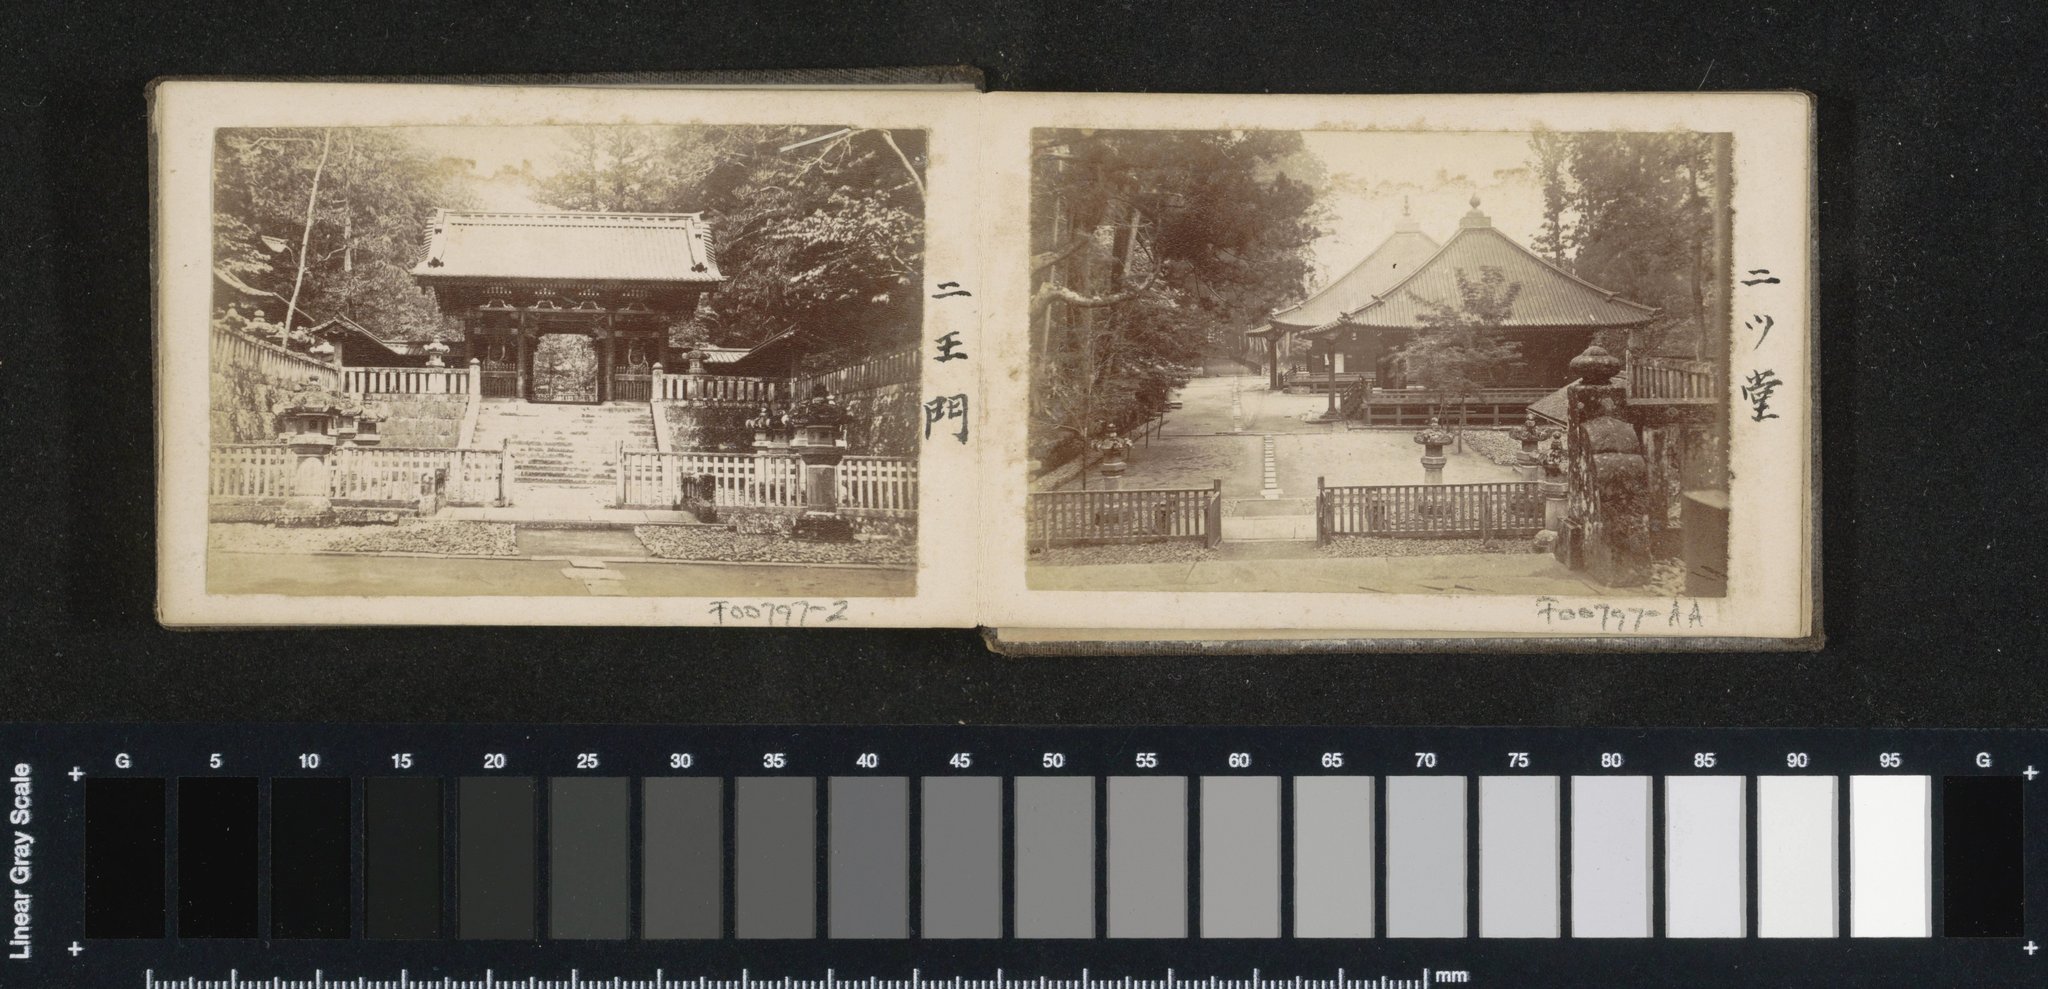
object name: photograph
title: Exterieur van tempelgebouwen in Japan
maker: Anonymous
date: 1870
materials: paper, photographic support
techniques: albumen print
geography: japan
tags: temple, shrine ~ hinduism, buddhism, jainism, japan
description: Onderdeel van Leporelloalbum met 30 foto's van landschappen en gebouwen in Japan.